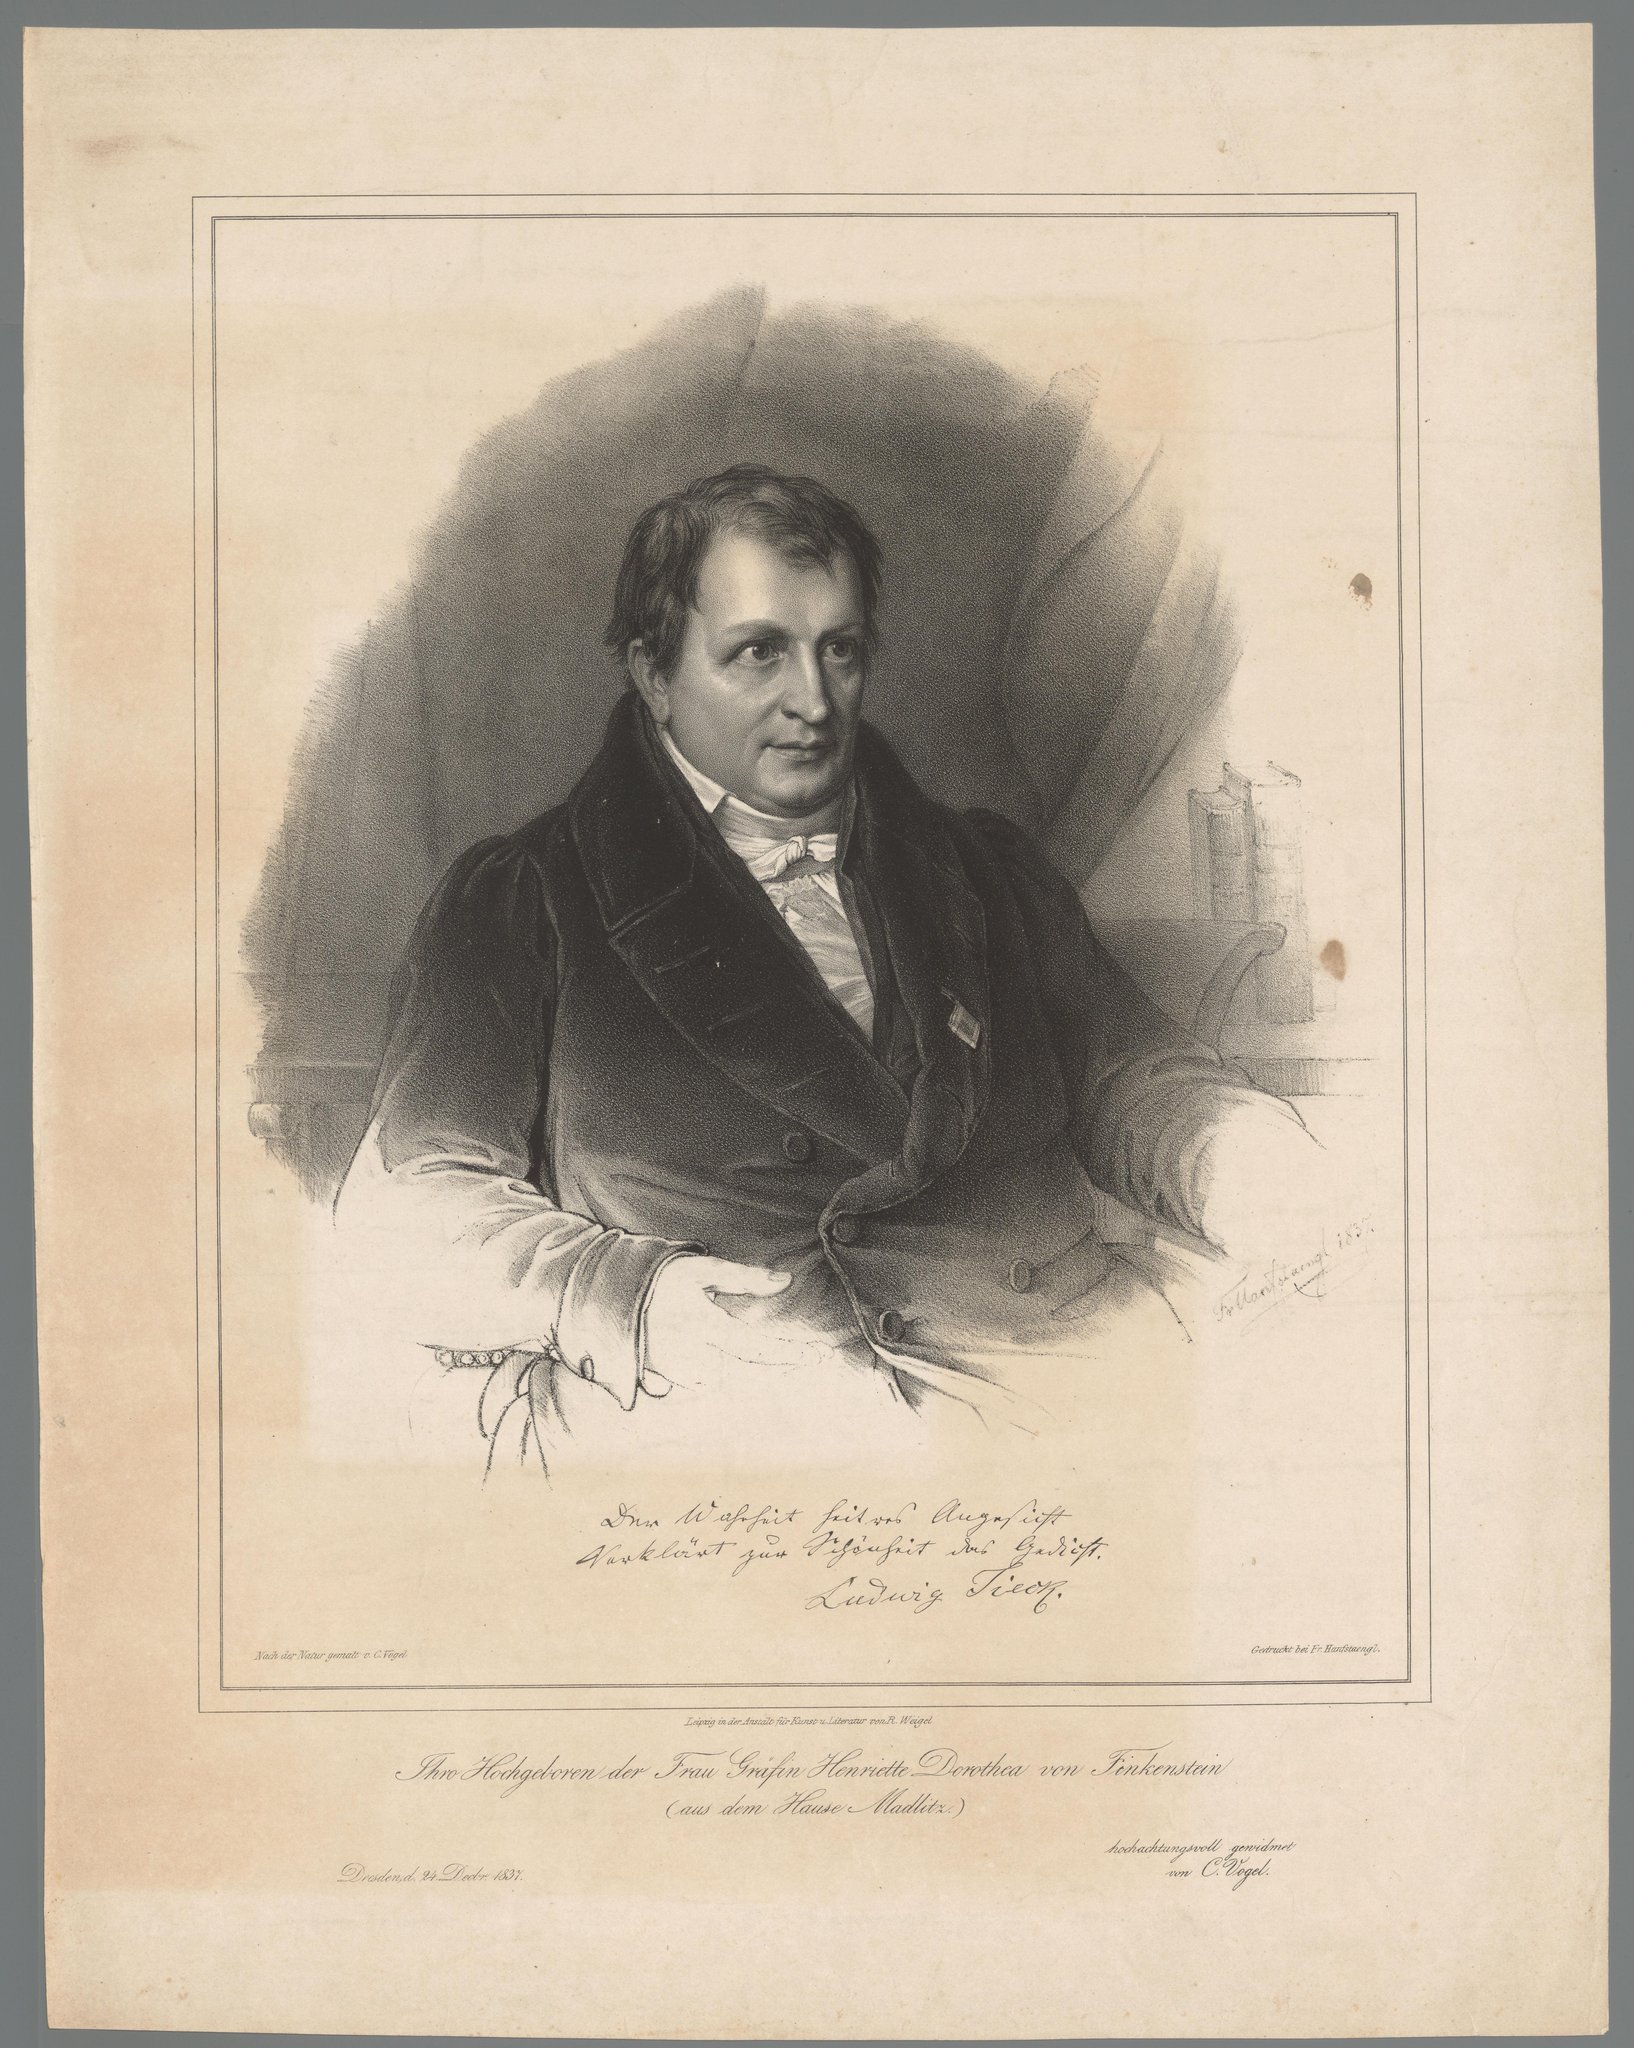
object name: print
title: Jhro Hochgeboren der Frau Gräfin Henriette Dorothea von Finkenstein (aus dem Hause Madlitz)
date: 1837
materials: paper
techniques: lithograph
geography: leipzig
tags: berlin, adult man, historical persons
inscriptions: collector's mark: Lugt 2228